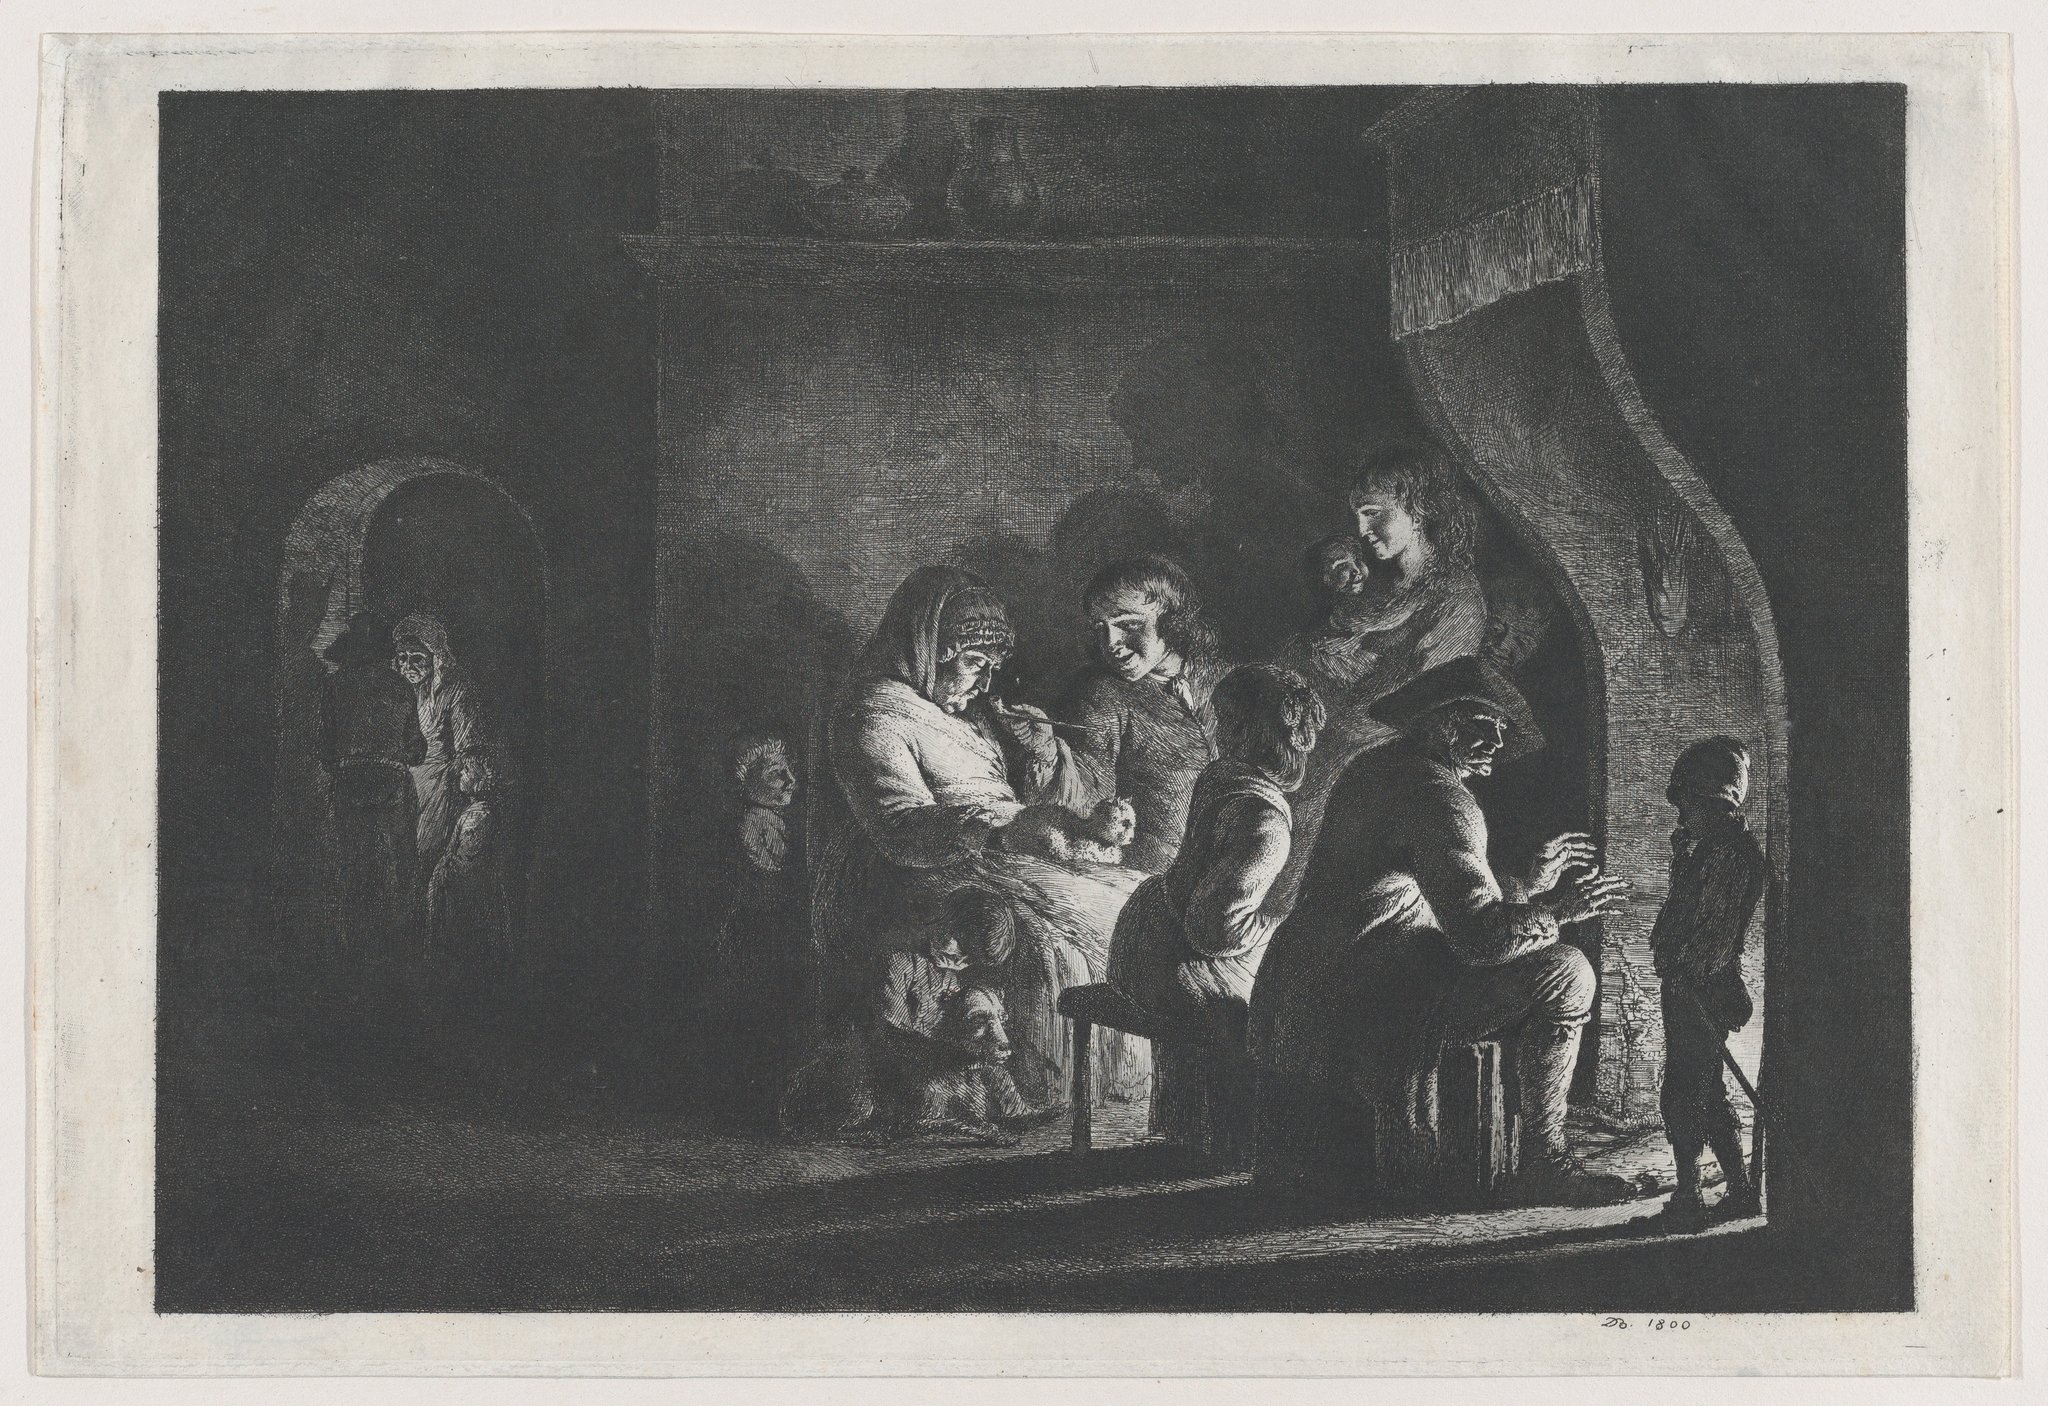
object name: print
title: Evening in the Village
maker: jean jacques de boissieu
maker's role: artist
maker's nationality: french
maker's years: 1736-1810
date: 1800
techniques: engraving, drypoint, etching, roulette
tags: infants,men,women,evening